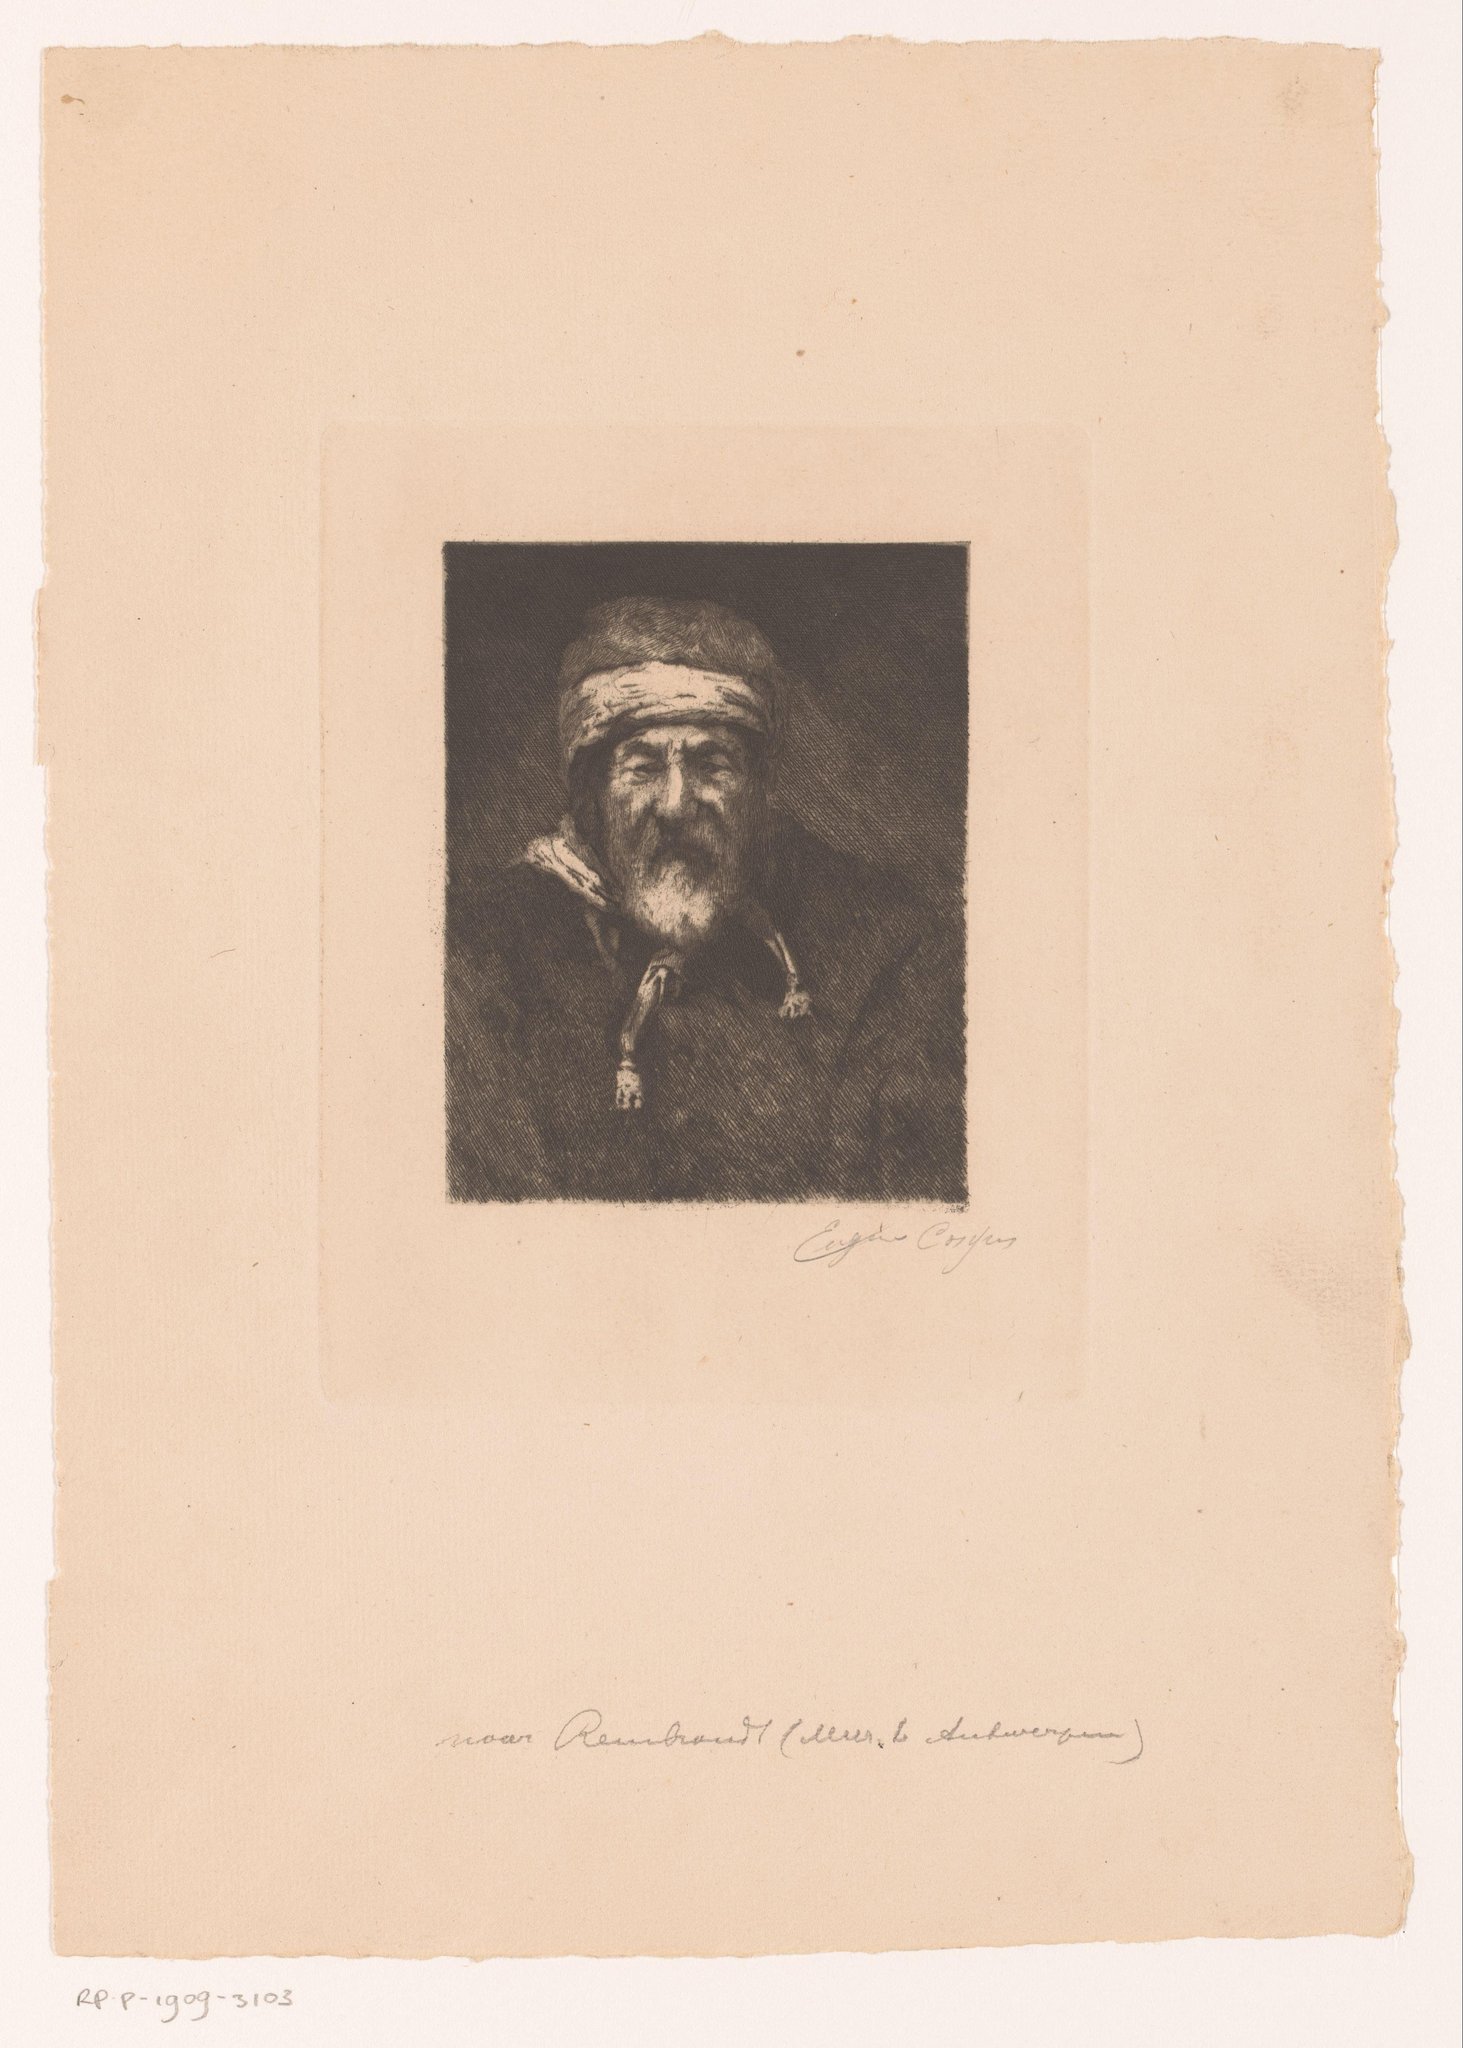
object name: print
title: Kop van een oude man met baard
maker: eugène cosyns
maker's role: print maker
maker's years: 1862-1909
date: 1872-1909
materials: paper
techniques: etching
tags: old man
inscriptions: collector's mark: Lugt 2228